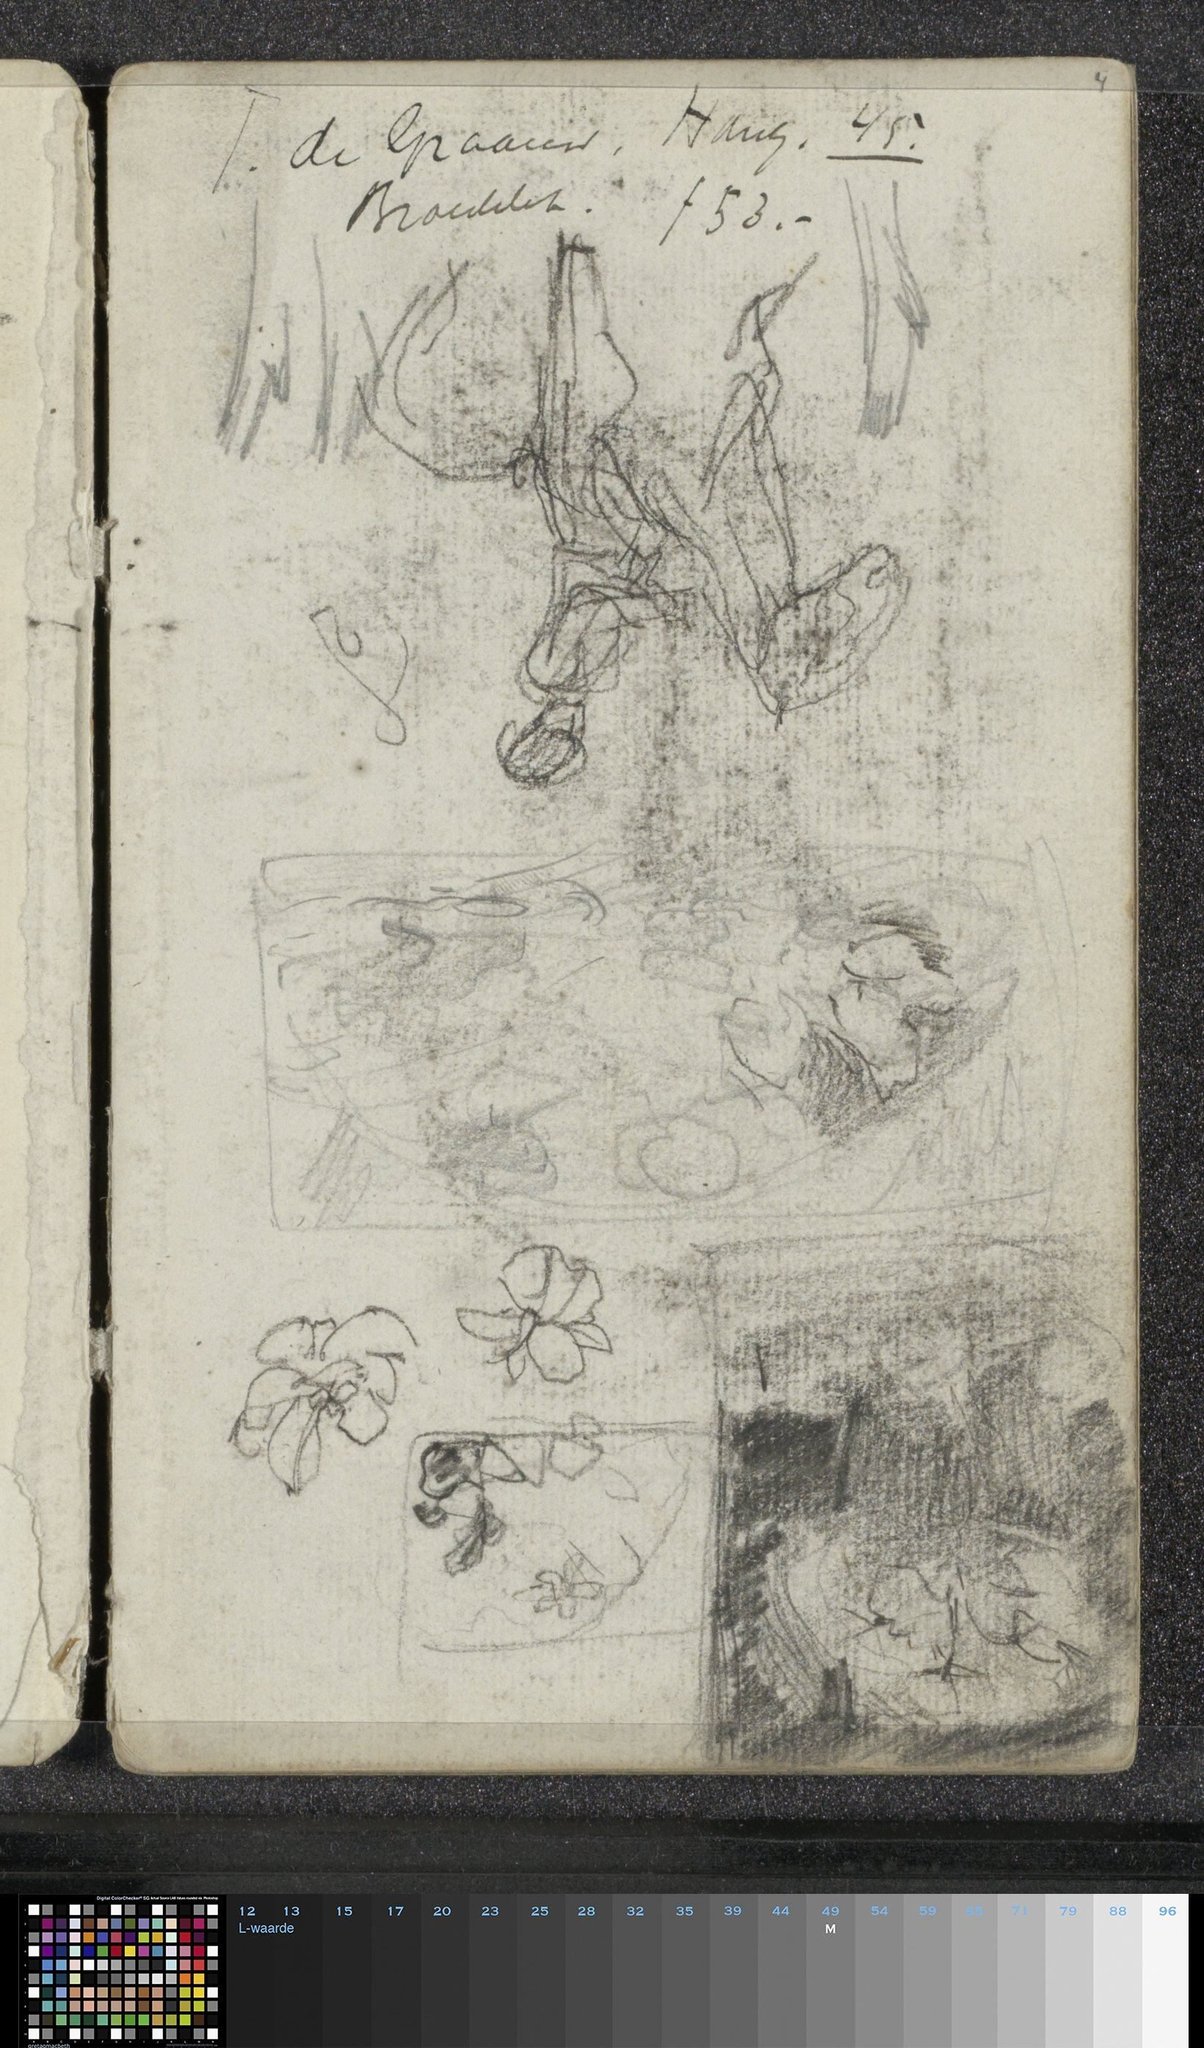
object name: sketchbook leaf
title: Studieblad, onder andere met een ruiter en bloemen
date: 1887-1889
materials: chalk, paper, pencil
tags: riding a horse, ass, or mule; rider, horseman, flowers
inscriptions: annotation: ‘T. de Graauw [...]’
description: Pagina 4 uit een schetsboek met 27 bladen.